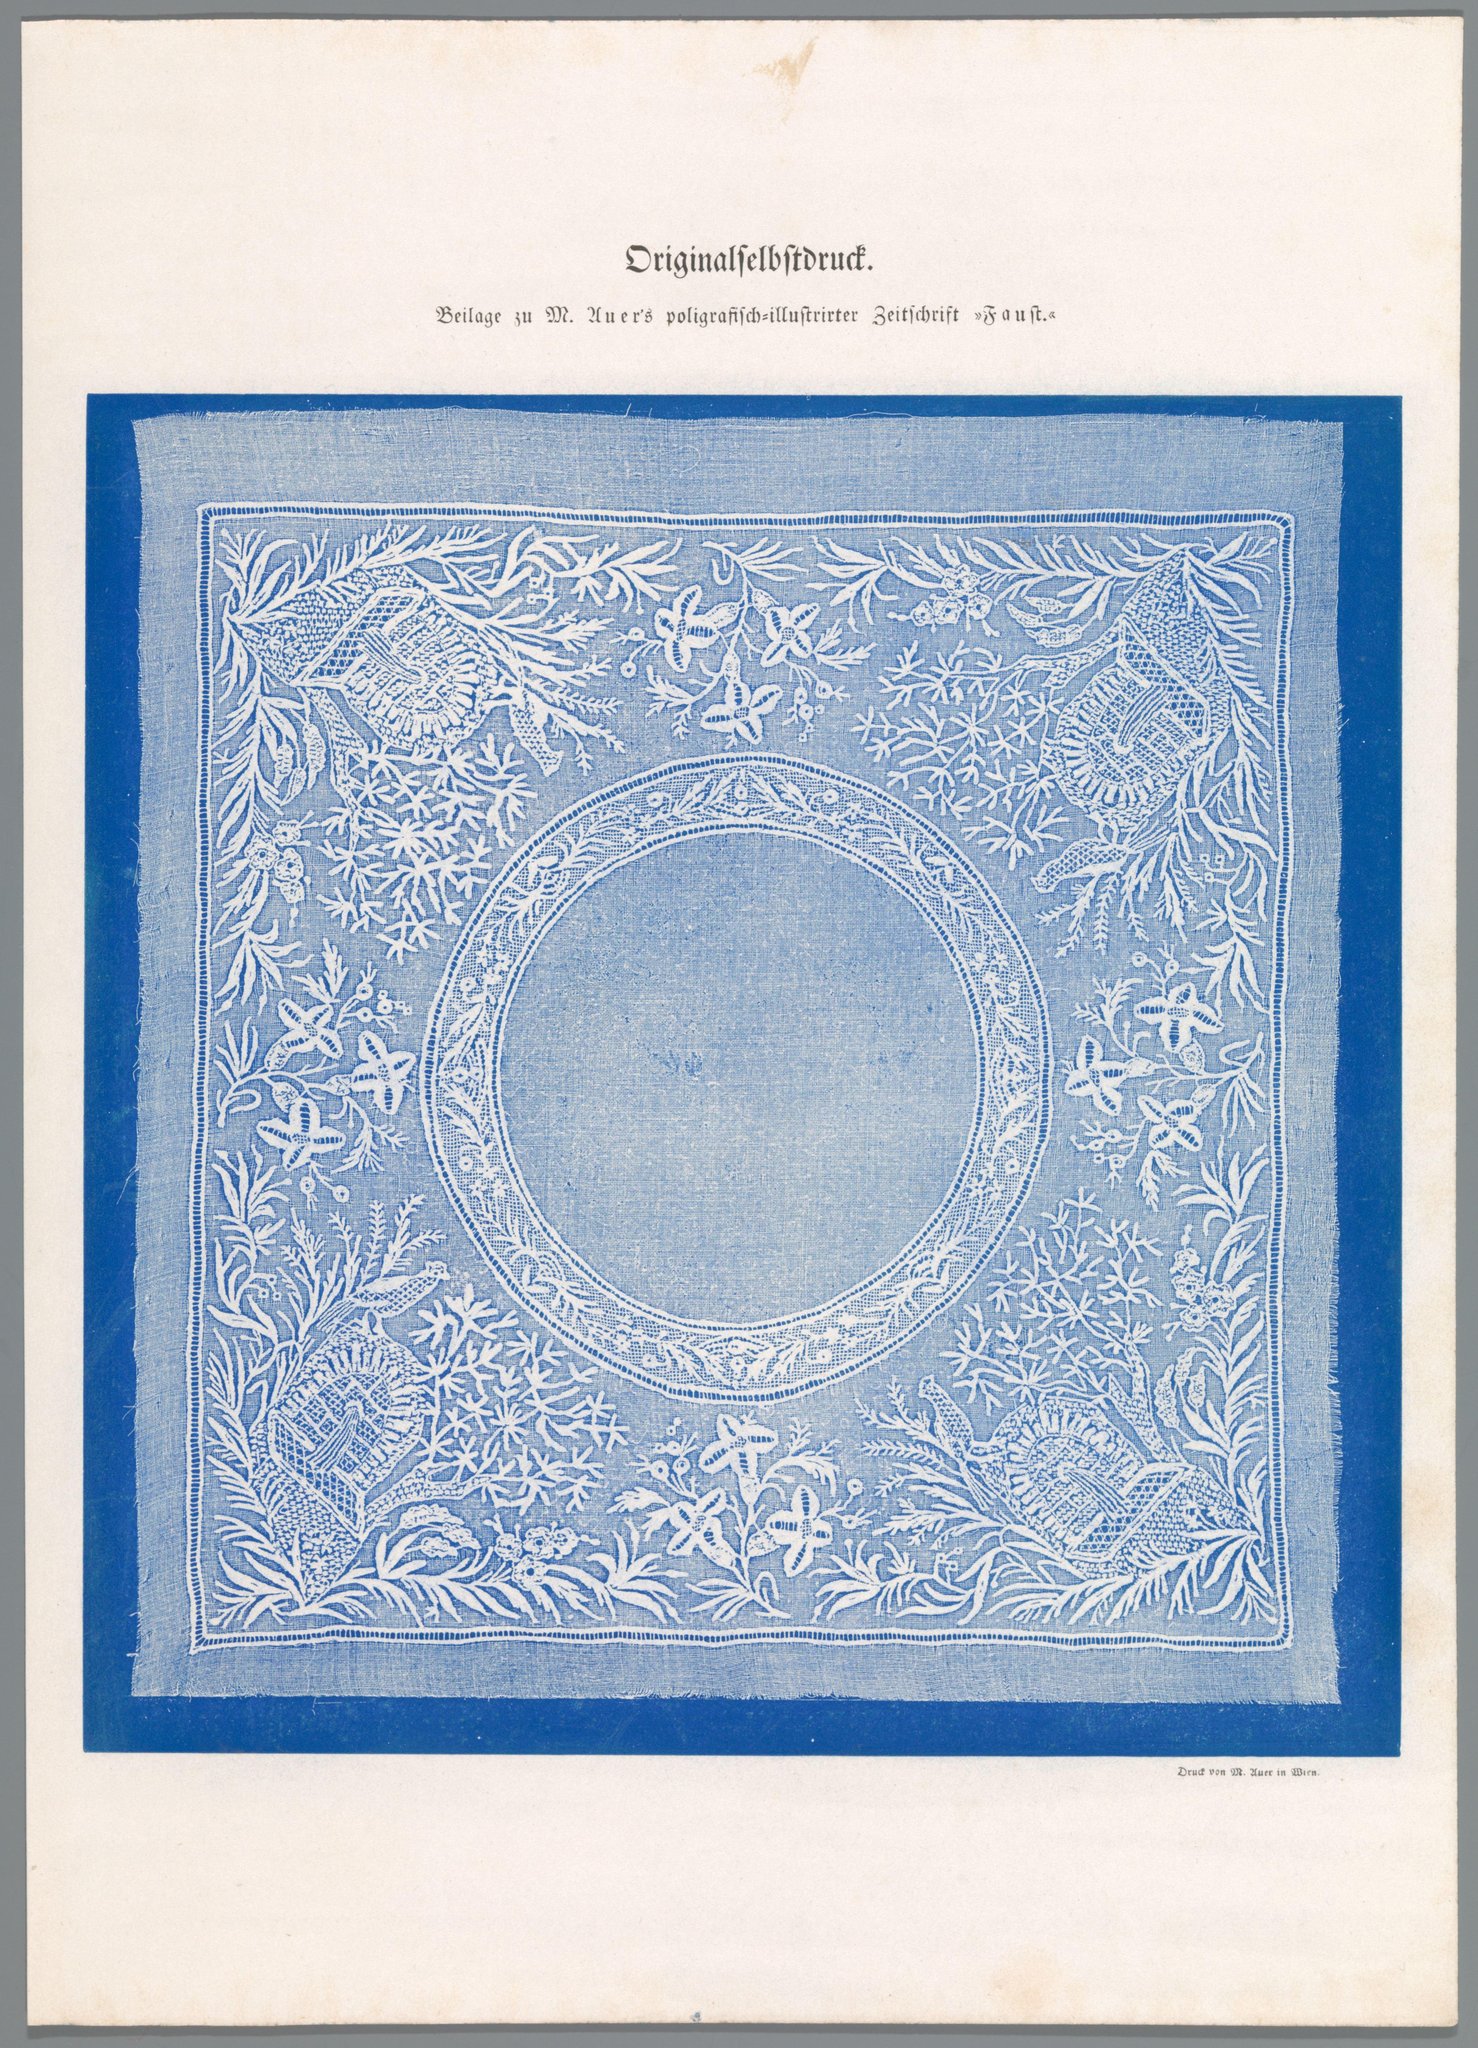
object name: print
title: Kantpatroon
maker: alois ritter von auer von welsbach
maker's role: printer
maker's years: 1813-1869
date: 1855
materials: paper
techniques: nature print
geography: vienna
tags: lace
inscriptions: inscription: ‘Originalselbstdruck./ Beilage zu M. Auer's poligrafisch-illustrierter Zeitschrift "Faust."’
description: Blad uit reeks van 16 Naturselbstdrucke Auer.